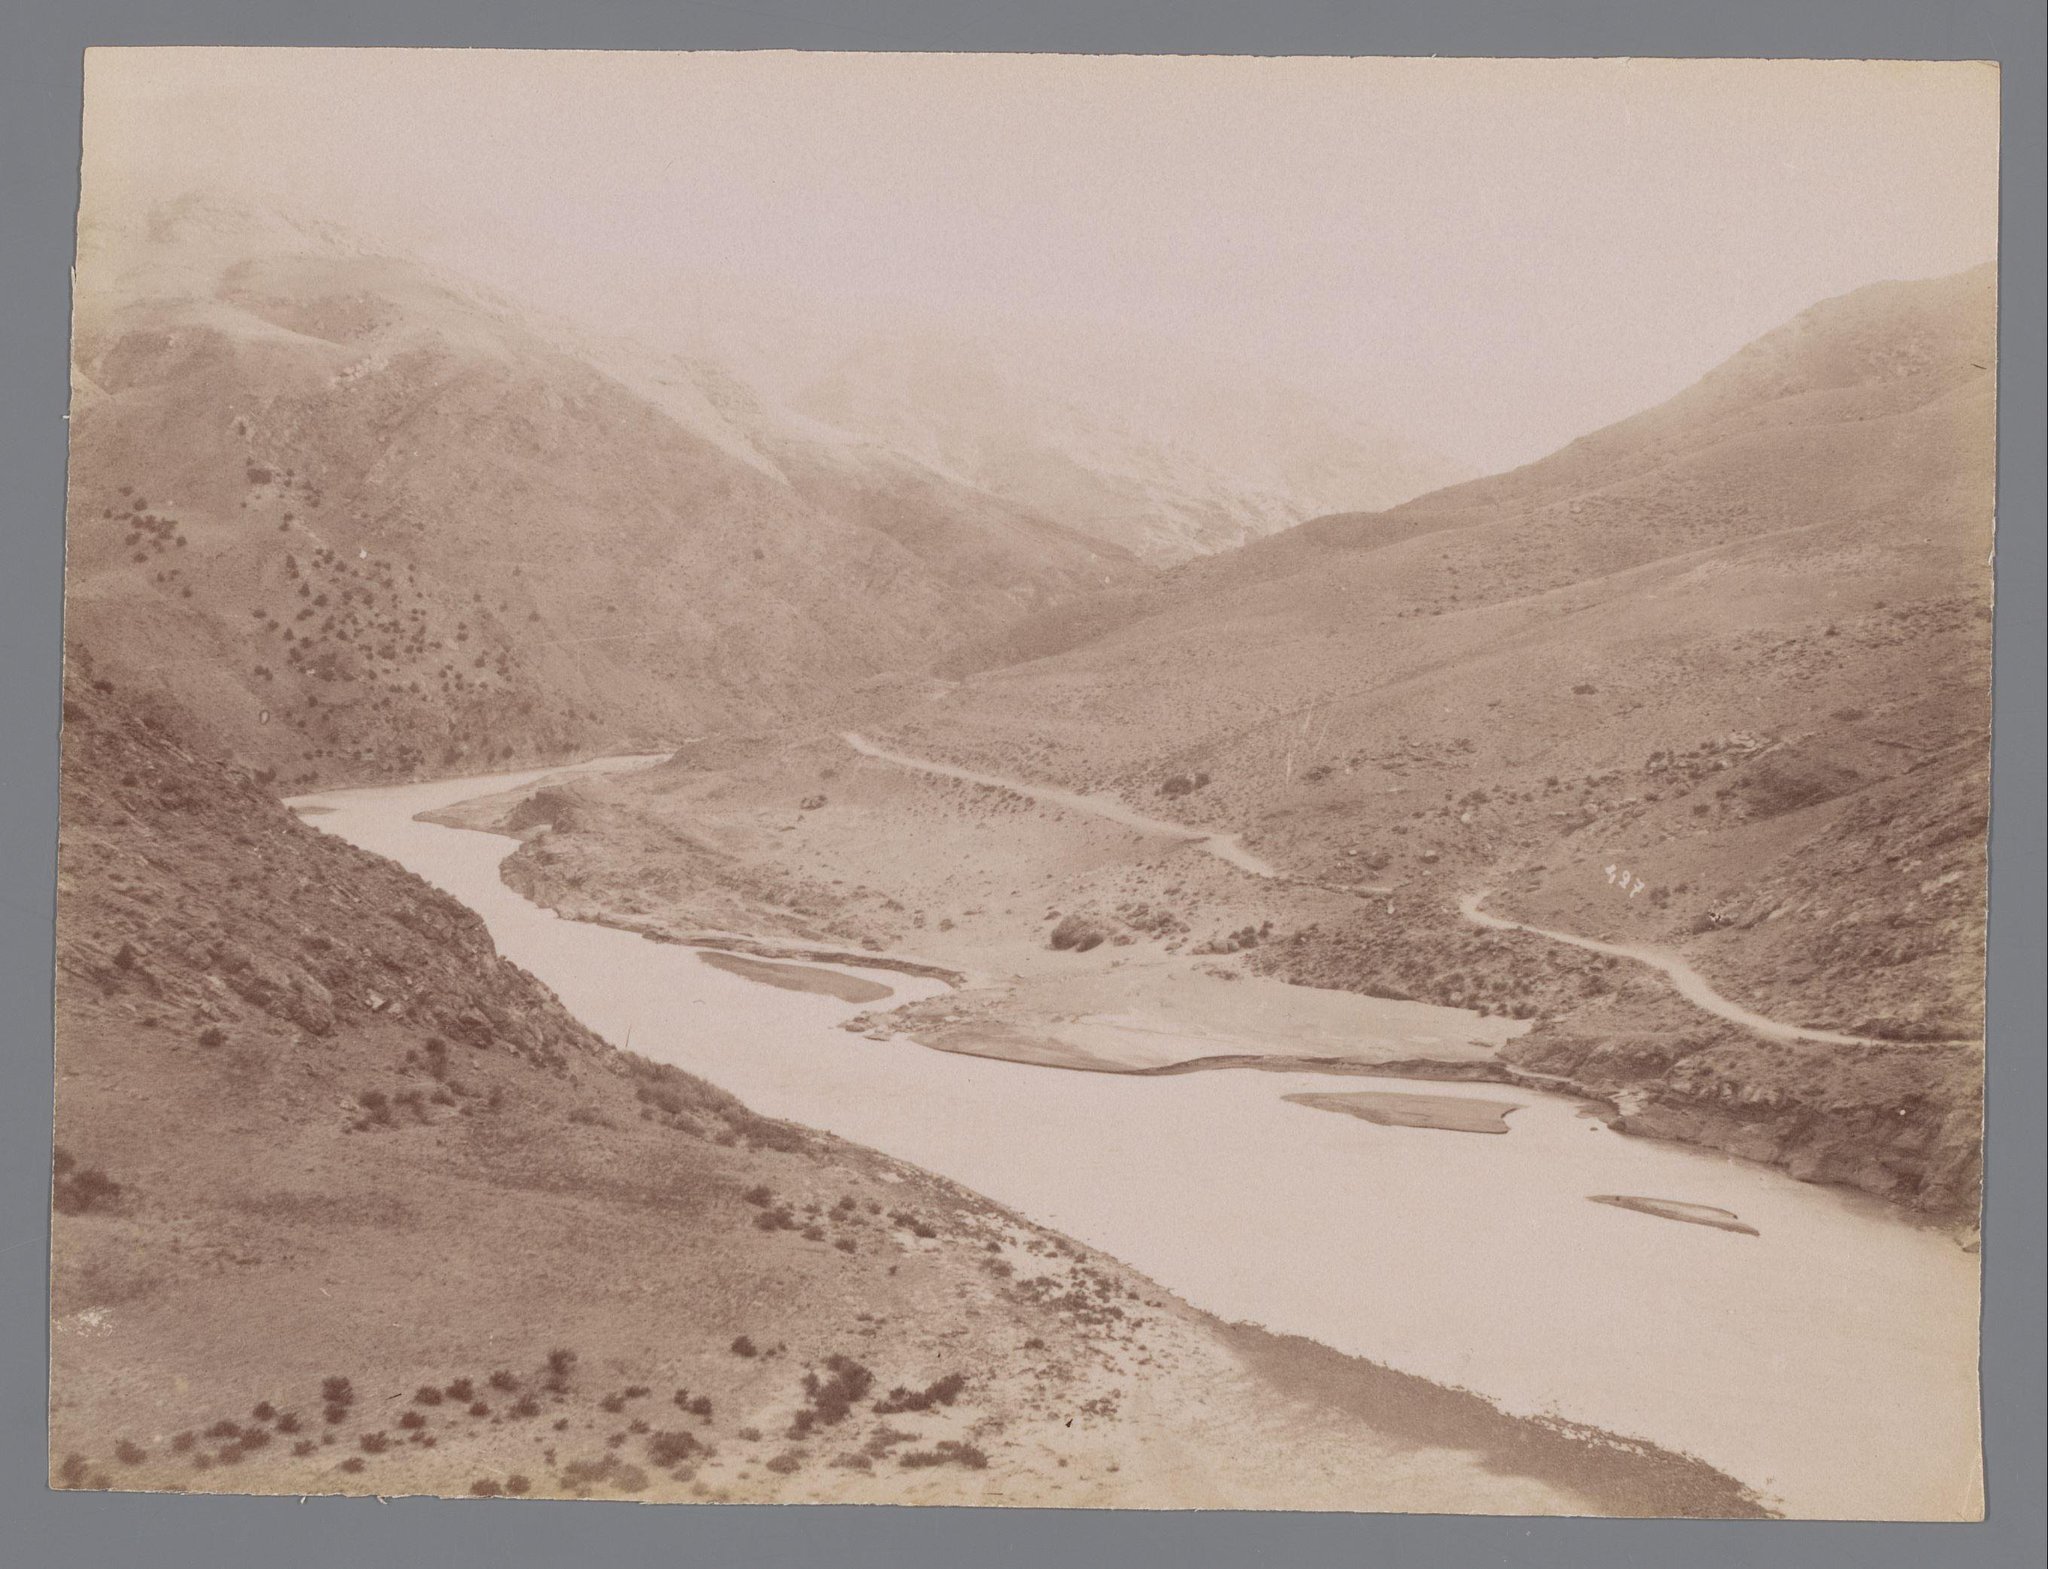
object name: photograph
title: Landschap met rivier en heuvels aan weerszijden ("La route de Rescht"), Iran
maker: antoine sevruguin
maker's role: fotograaf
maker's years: 1840-1933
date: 1880-1910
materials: paper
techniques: albumen print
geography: iran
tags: iran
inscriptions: inscription: ‘La route de Rescht’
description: Landschap met rivier en heuvels aan weerszijden ("La route de Rescht"), Iran.